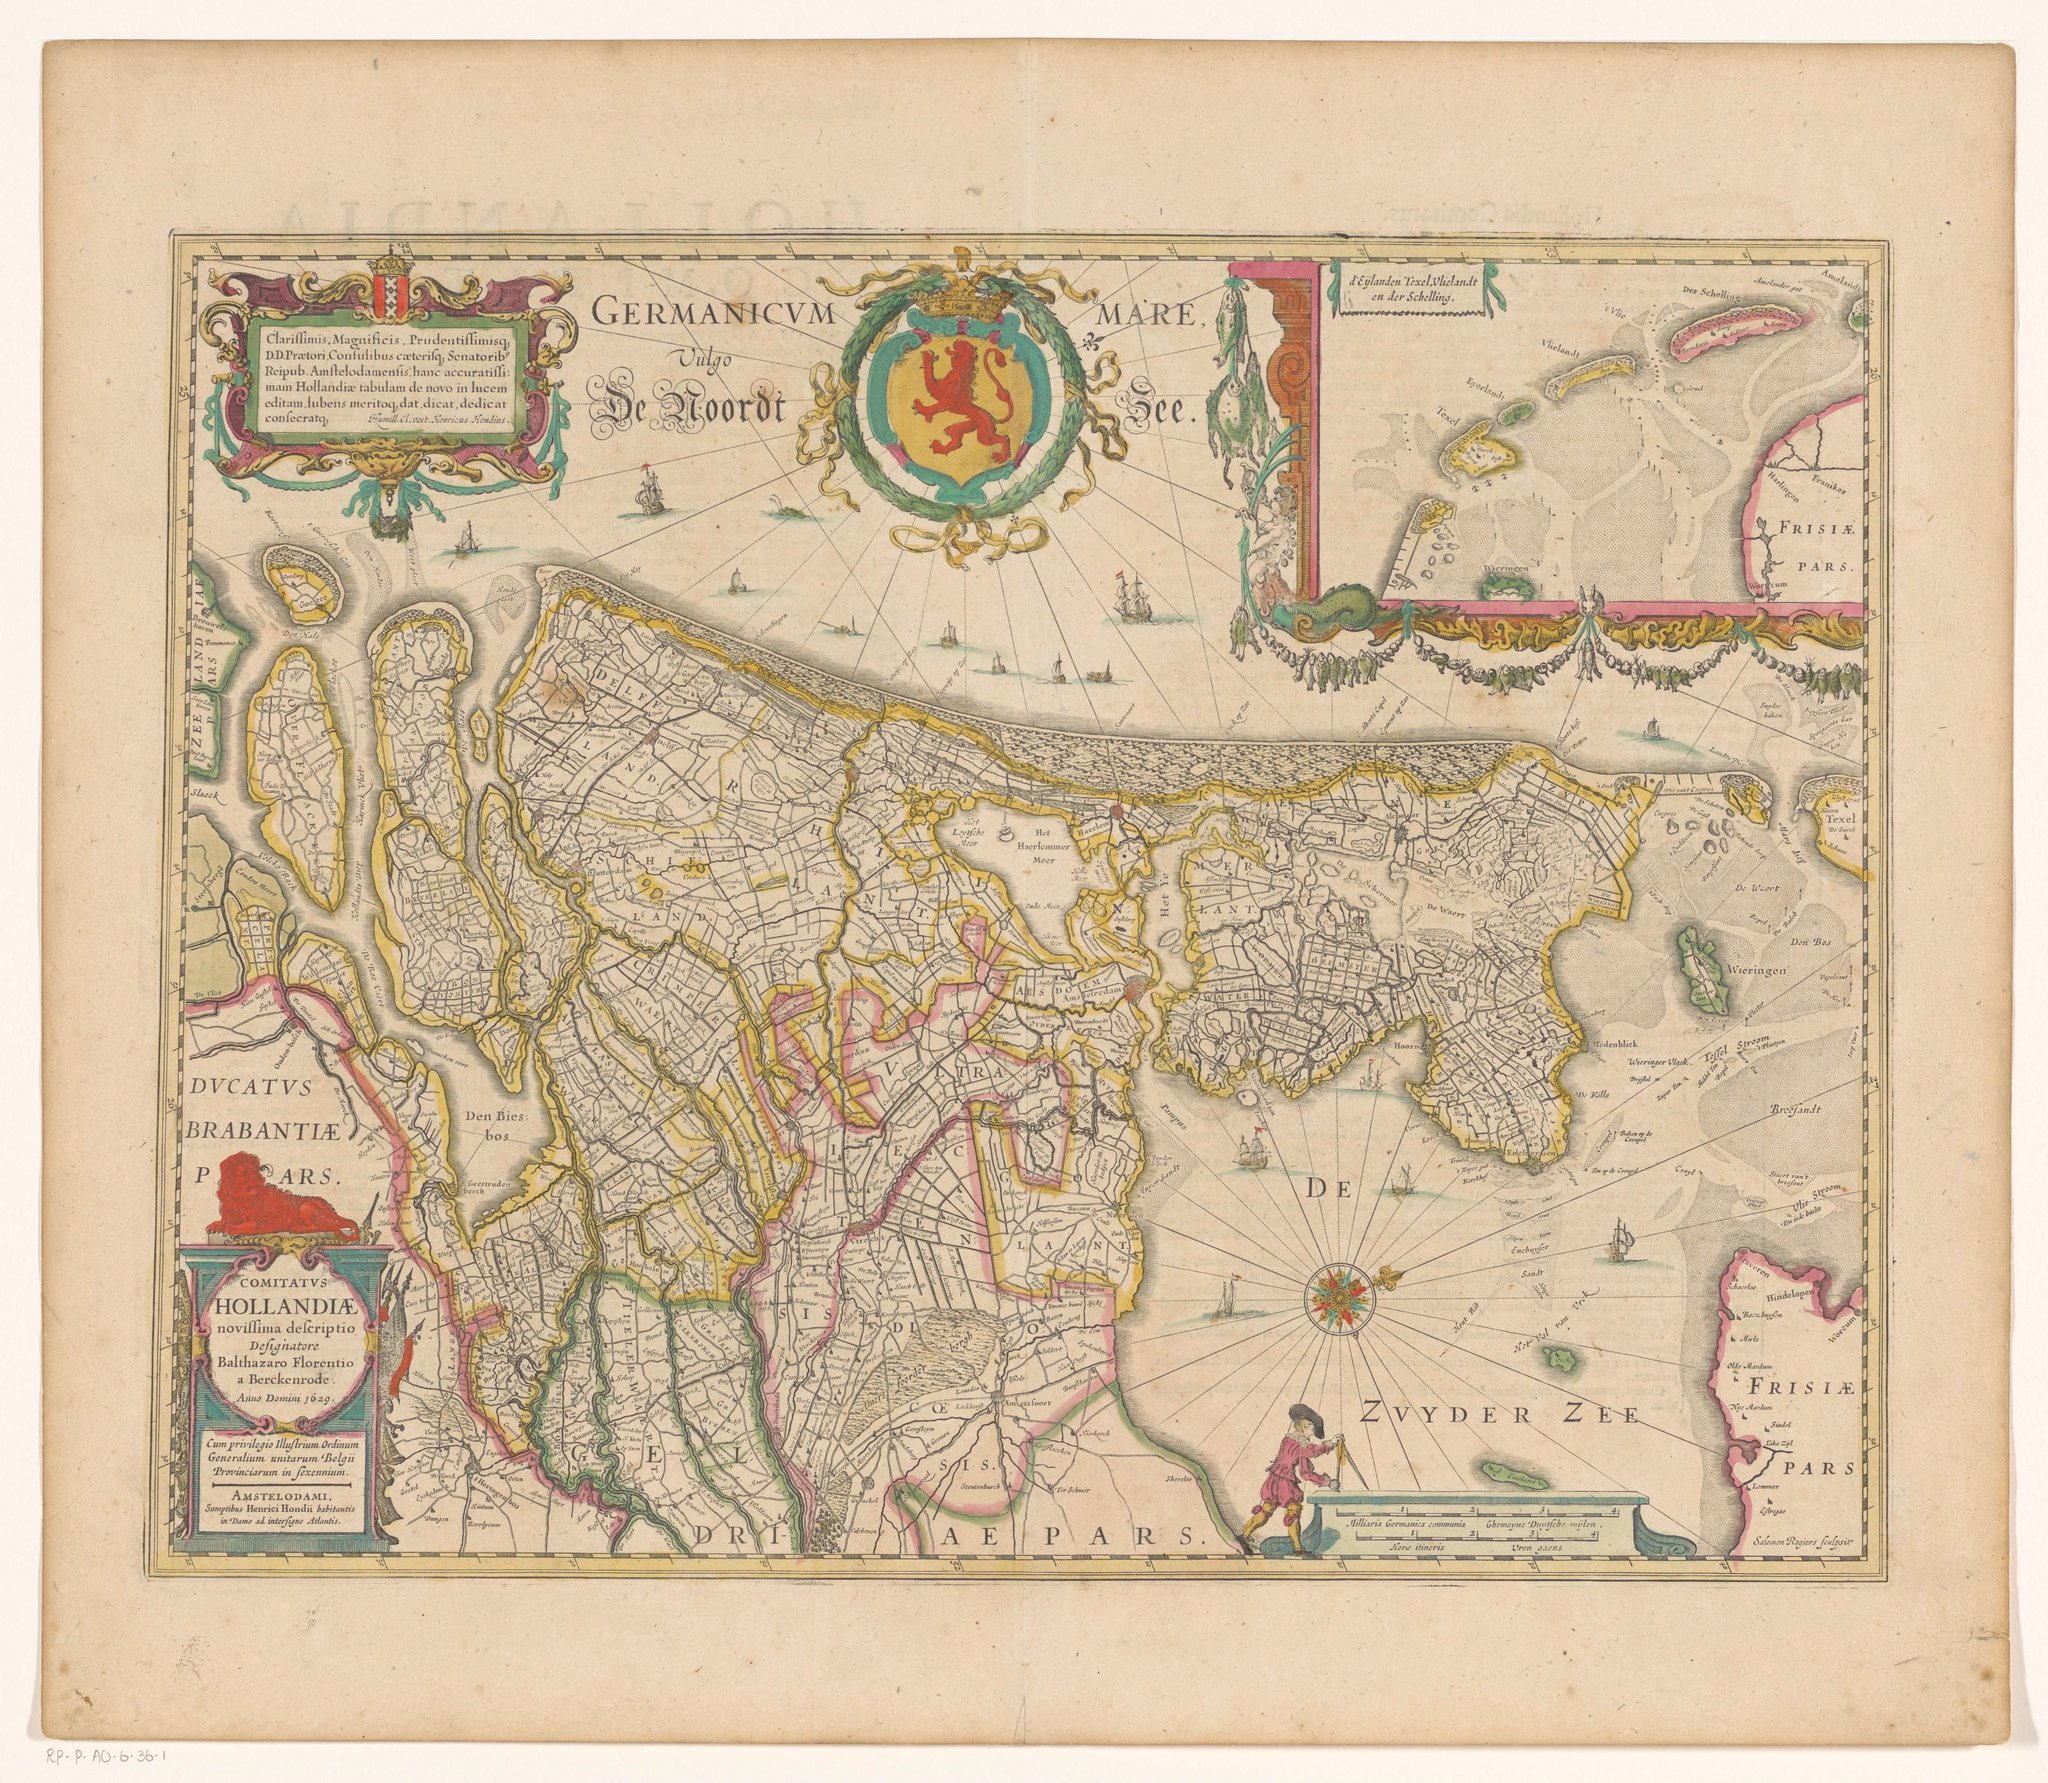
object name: map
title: Comitatus Hollandiae novissima descriptio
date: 1629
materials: paper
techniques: engraving, etching, hand coloring, letterpress printing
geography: amsterdam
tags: triton(s), maps of separate countries or regions, holland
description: Linksboven een cartouche met het wapen van de stad Amsterdam en de opdracht. Linksonder de titelcartouche. Boven in het midden een lauwerkrans met het wapen van het graafschap Holland. Rechtsboven een inzetkaart van het Waddengebied met daaromheen een triton en vissen. Rechtsonder twee schaalstokken: Milliaria Germanica communia / Ghemeyne Duytsche mijlen; Hore itineris / Uren gaens. Gradenverdeling langs de randen. Oriëntatie: noorden rechts. Op verso Latijnse tekst.